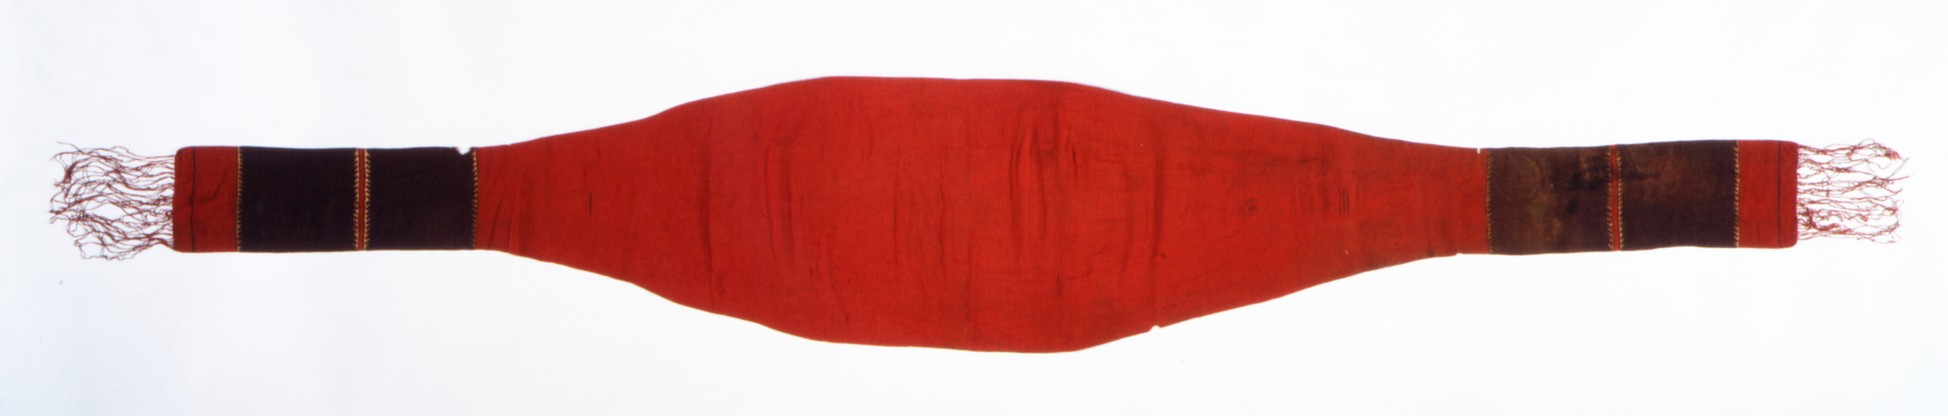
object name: scarf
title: Possibly a Ceremonial Scarf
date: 401-600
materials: linen, wool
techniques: weave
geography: egypt